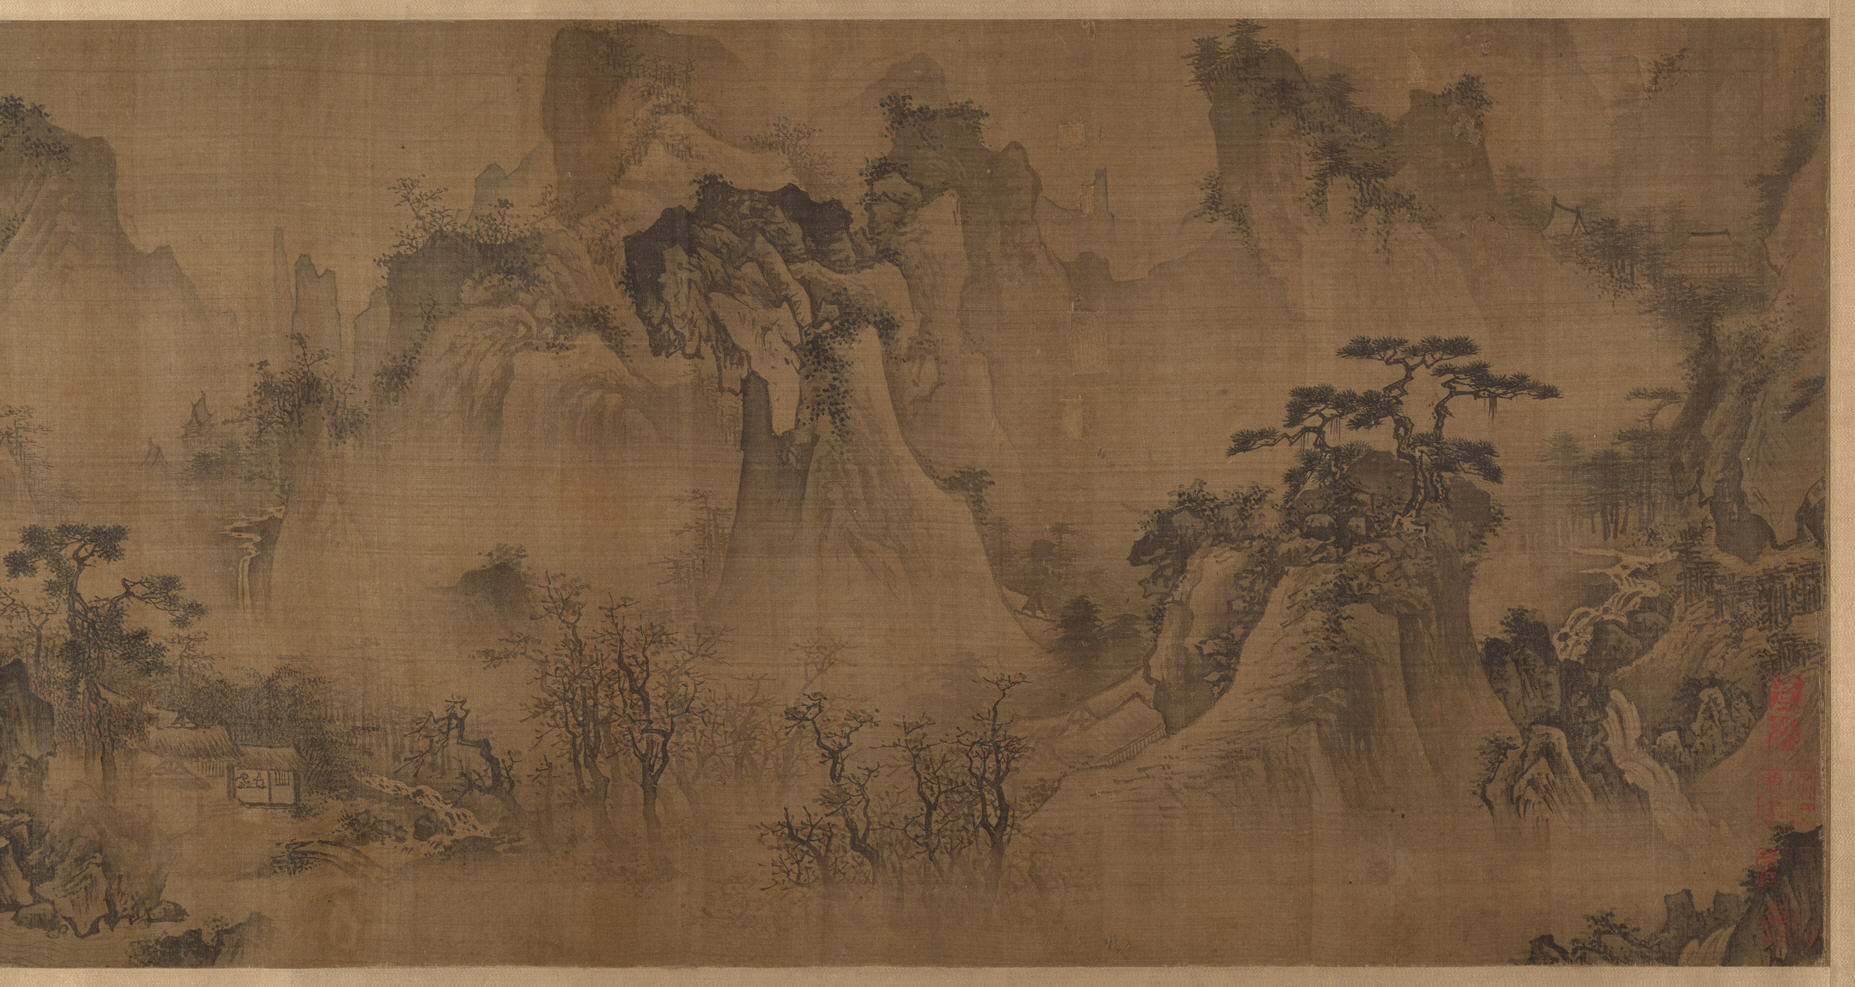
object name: handscroll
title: The Four Seasons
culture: chinese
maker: unidentified artist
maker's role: artist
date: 1401-1500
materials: ink, silk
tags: mountains,landscapes